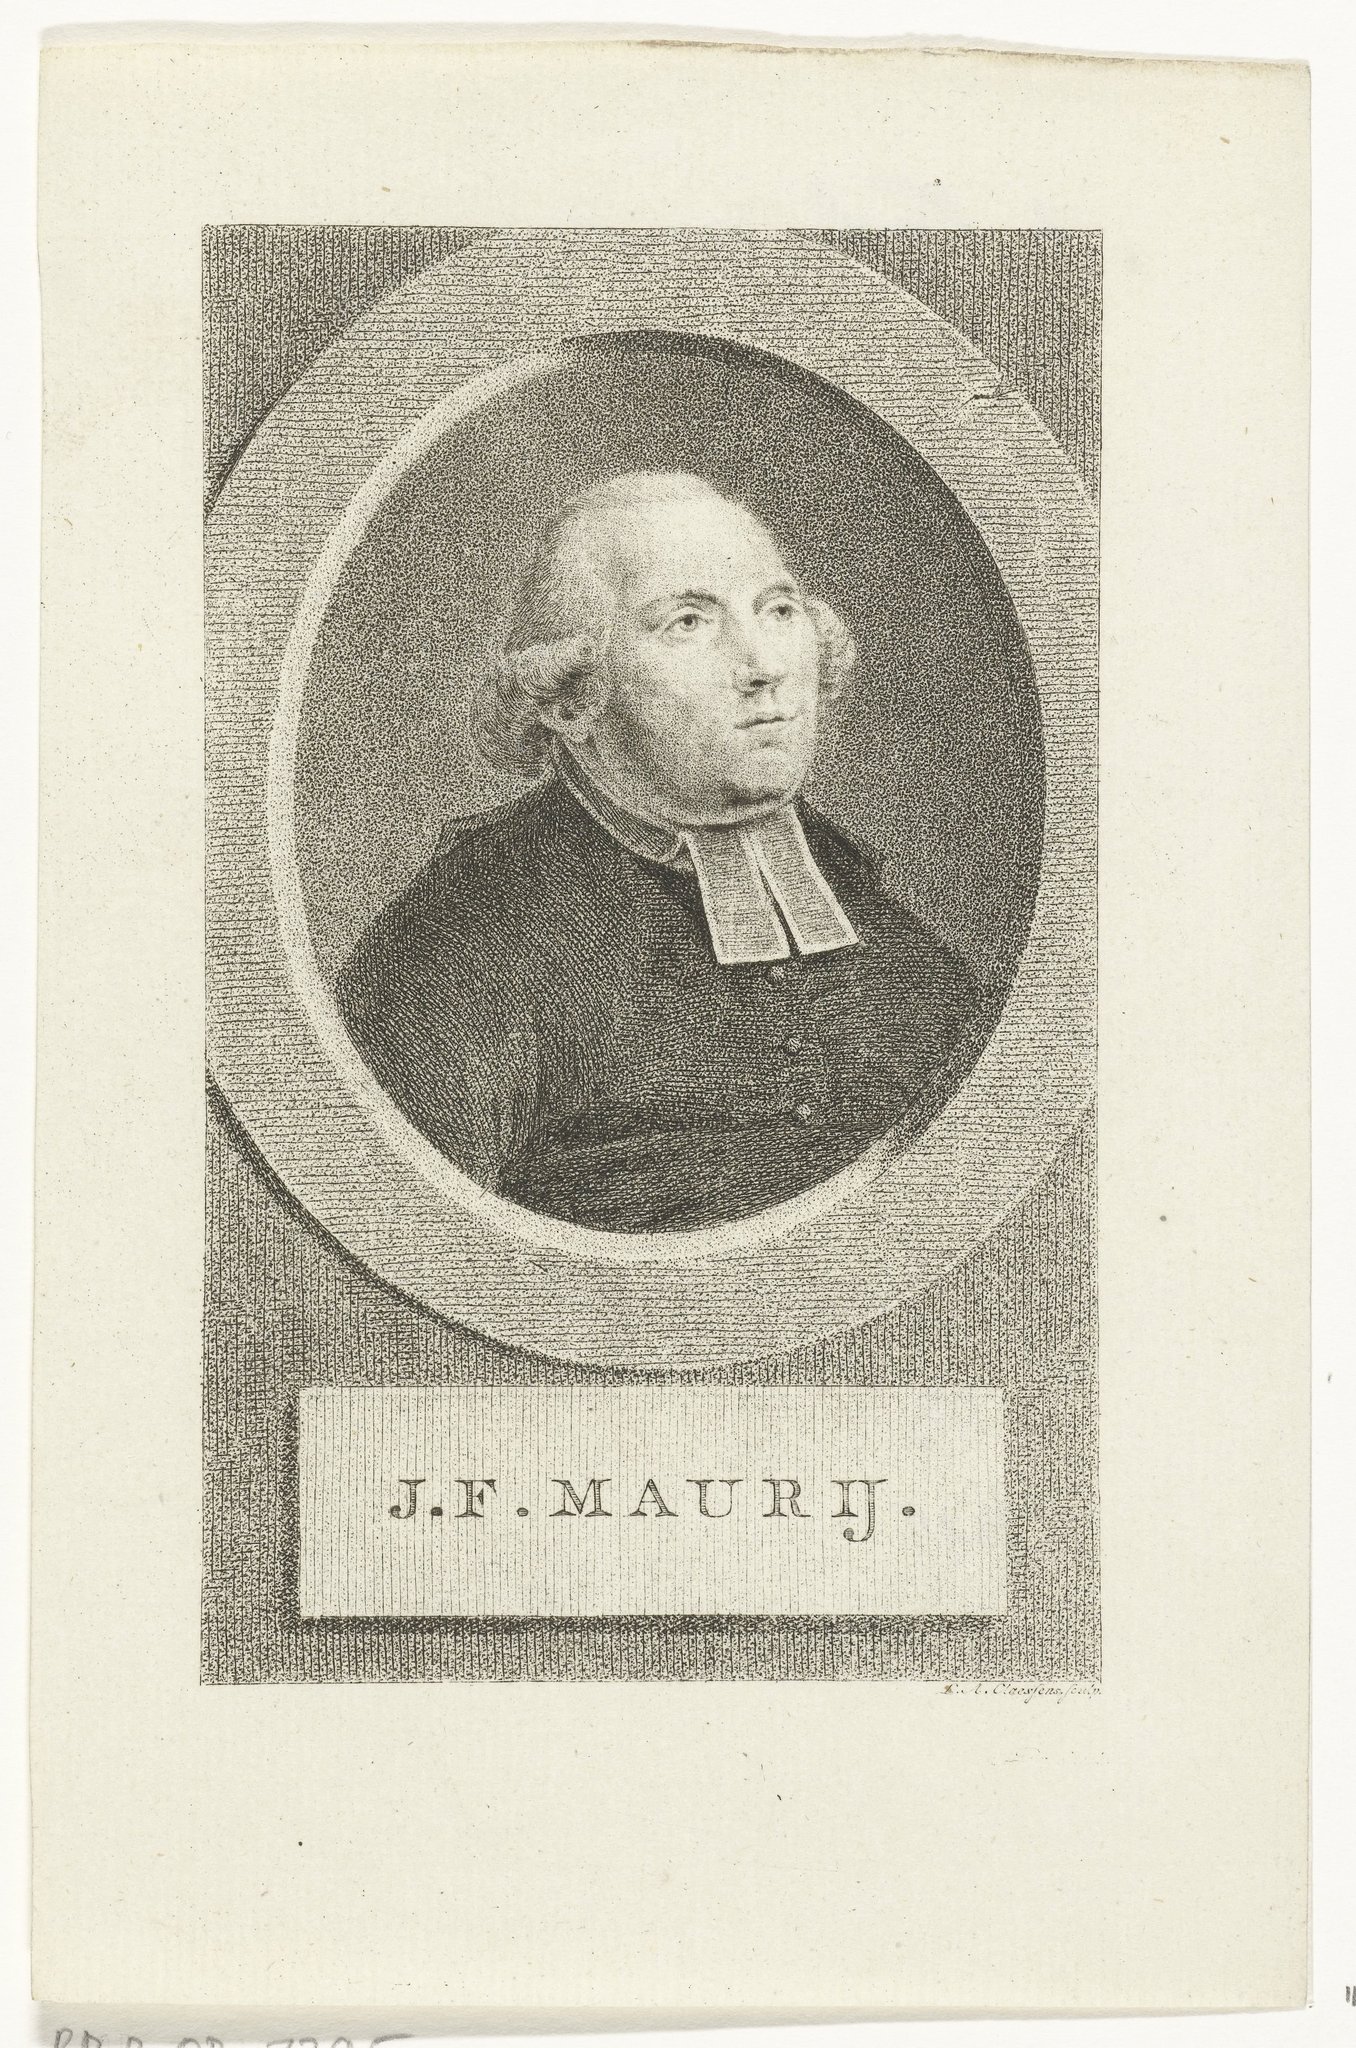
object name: print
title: Portret van aartsbisschop Jean-Sifrein Maury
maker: lambertus antonius claessens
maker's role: draughtsman, print maker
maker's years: 1763-1834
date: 1792-1808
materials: paper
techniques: engraving, etching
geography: amsterdam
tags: jean sifrein maury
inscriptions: collector's mark: Lugt 2228